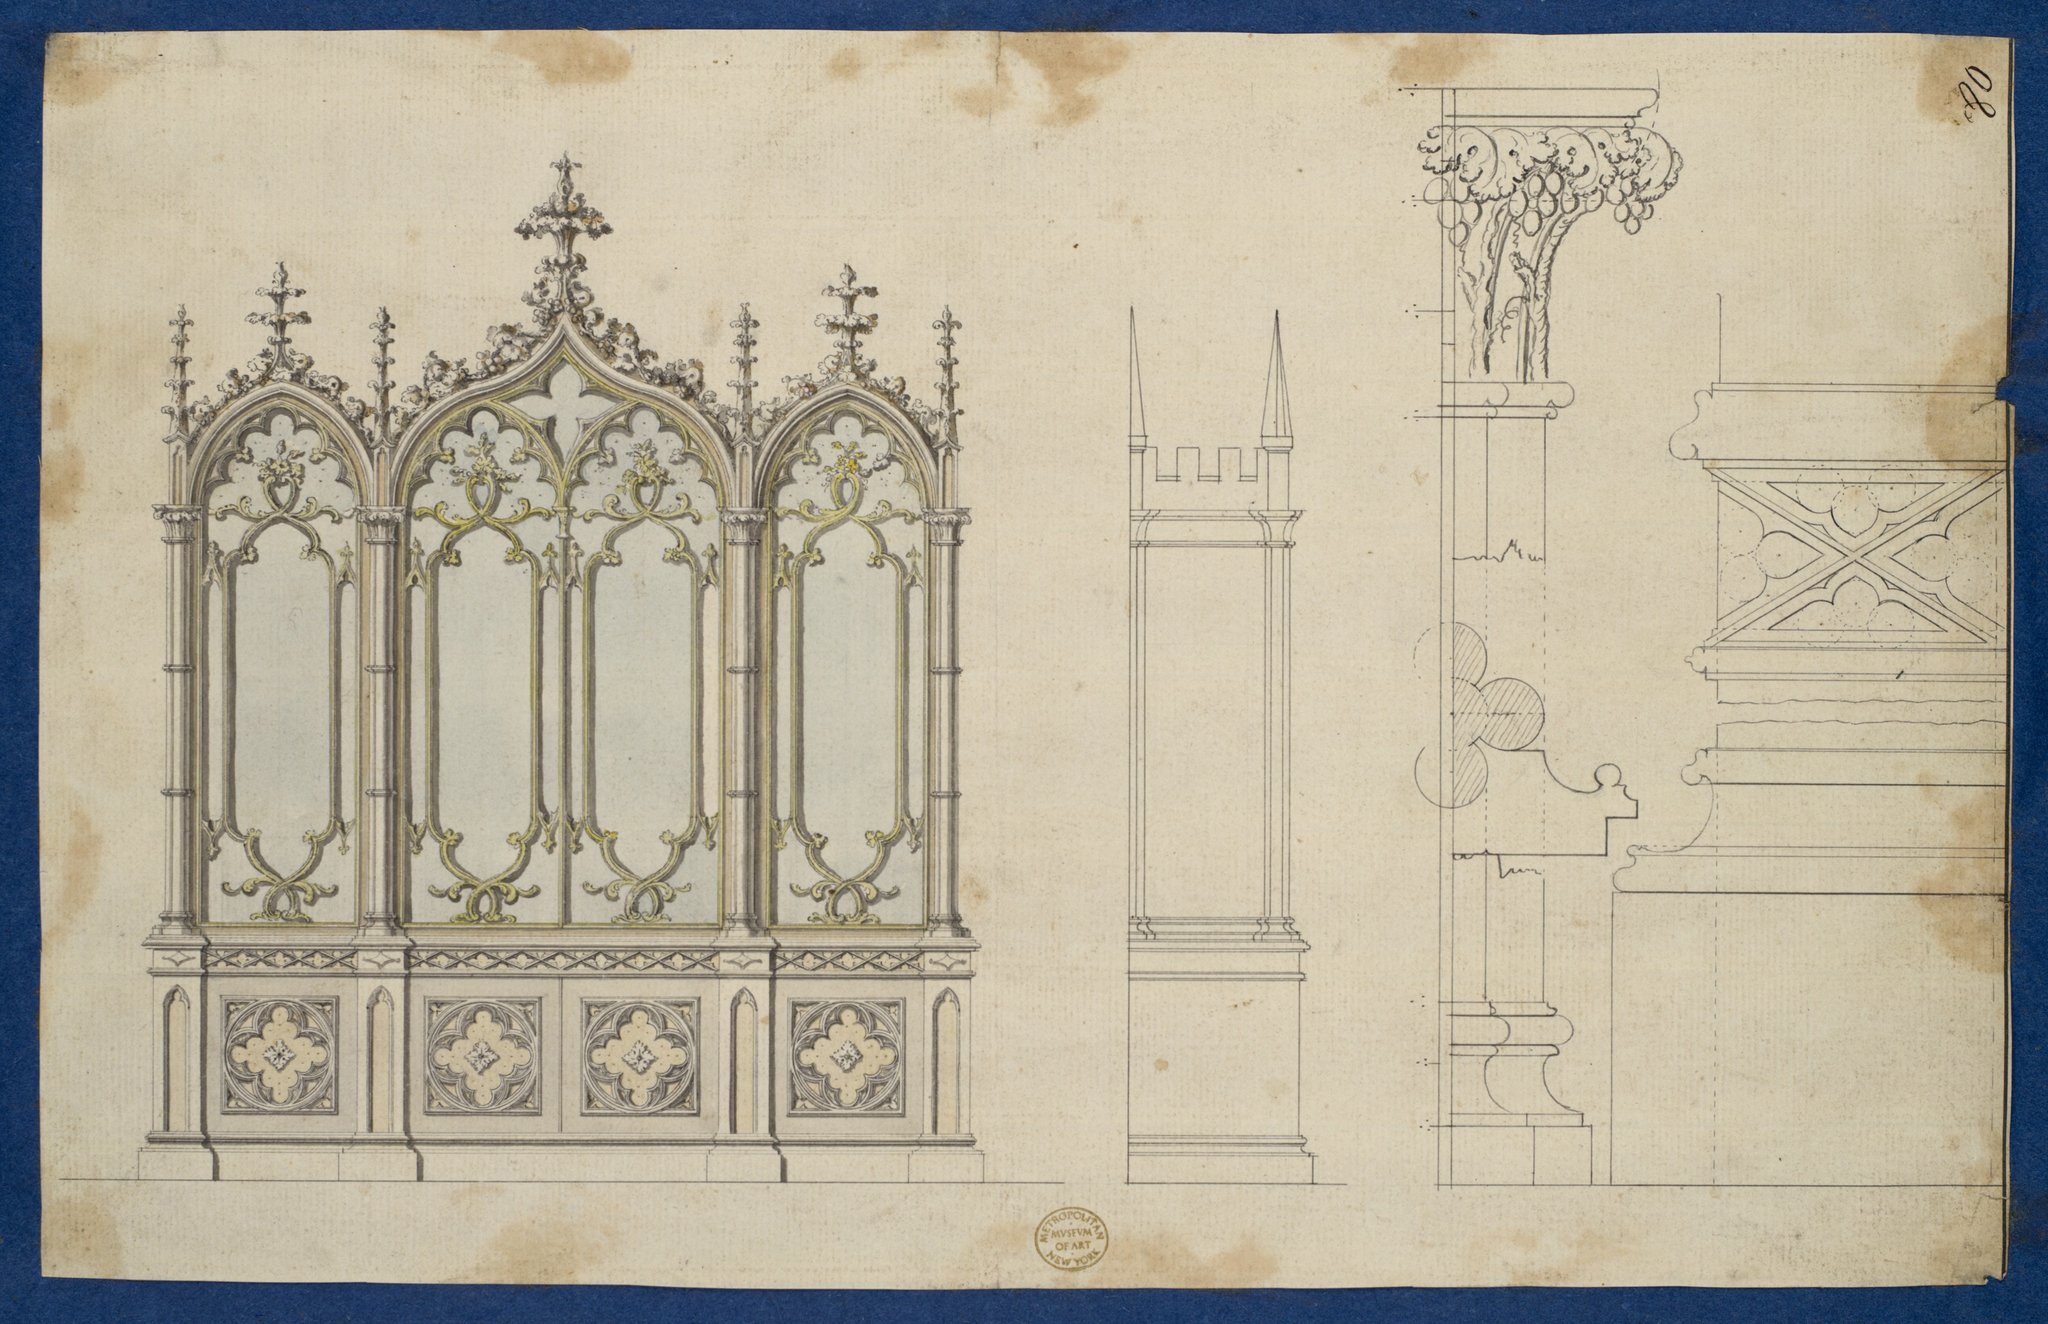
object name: drawing ornament architecture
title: Gothic Bookcase, from Chippendale Drawings, Vol. II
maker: thomas chippendale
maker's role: artist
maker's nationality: british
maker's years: 1718-1779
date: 1761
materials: ink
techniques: wash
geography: london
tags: furniture